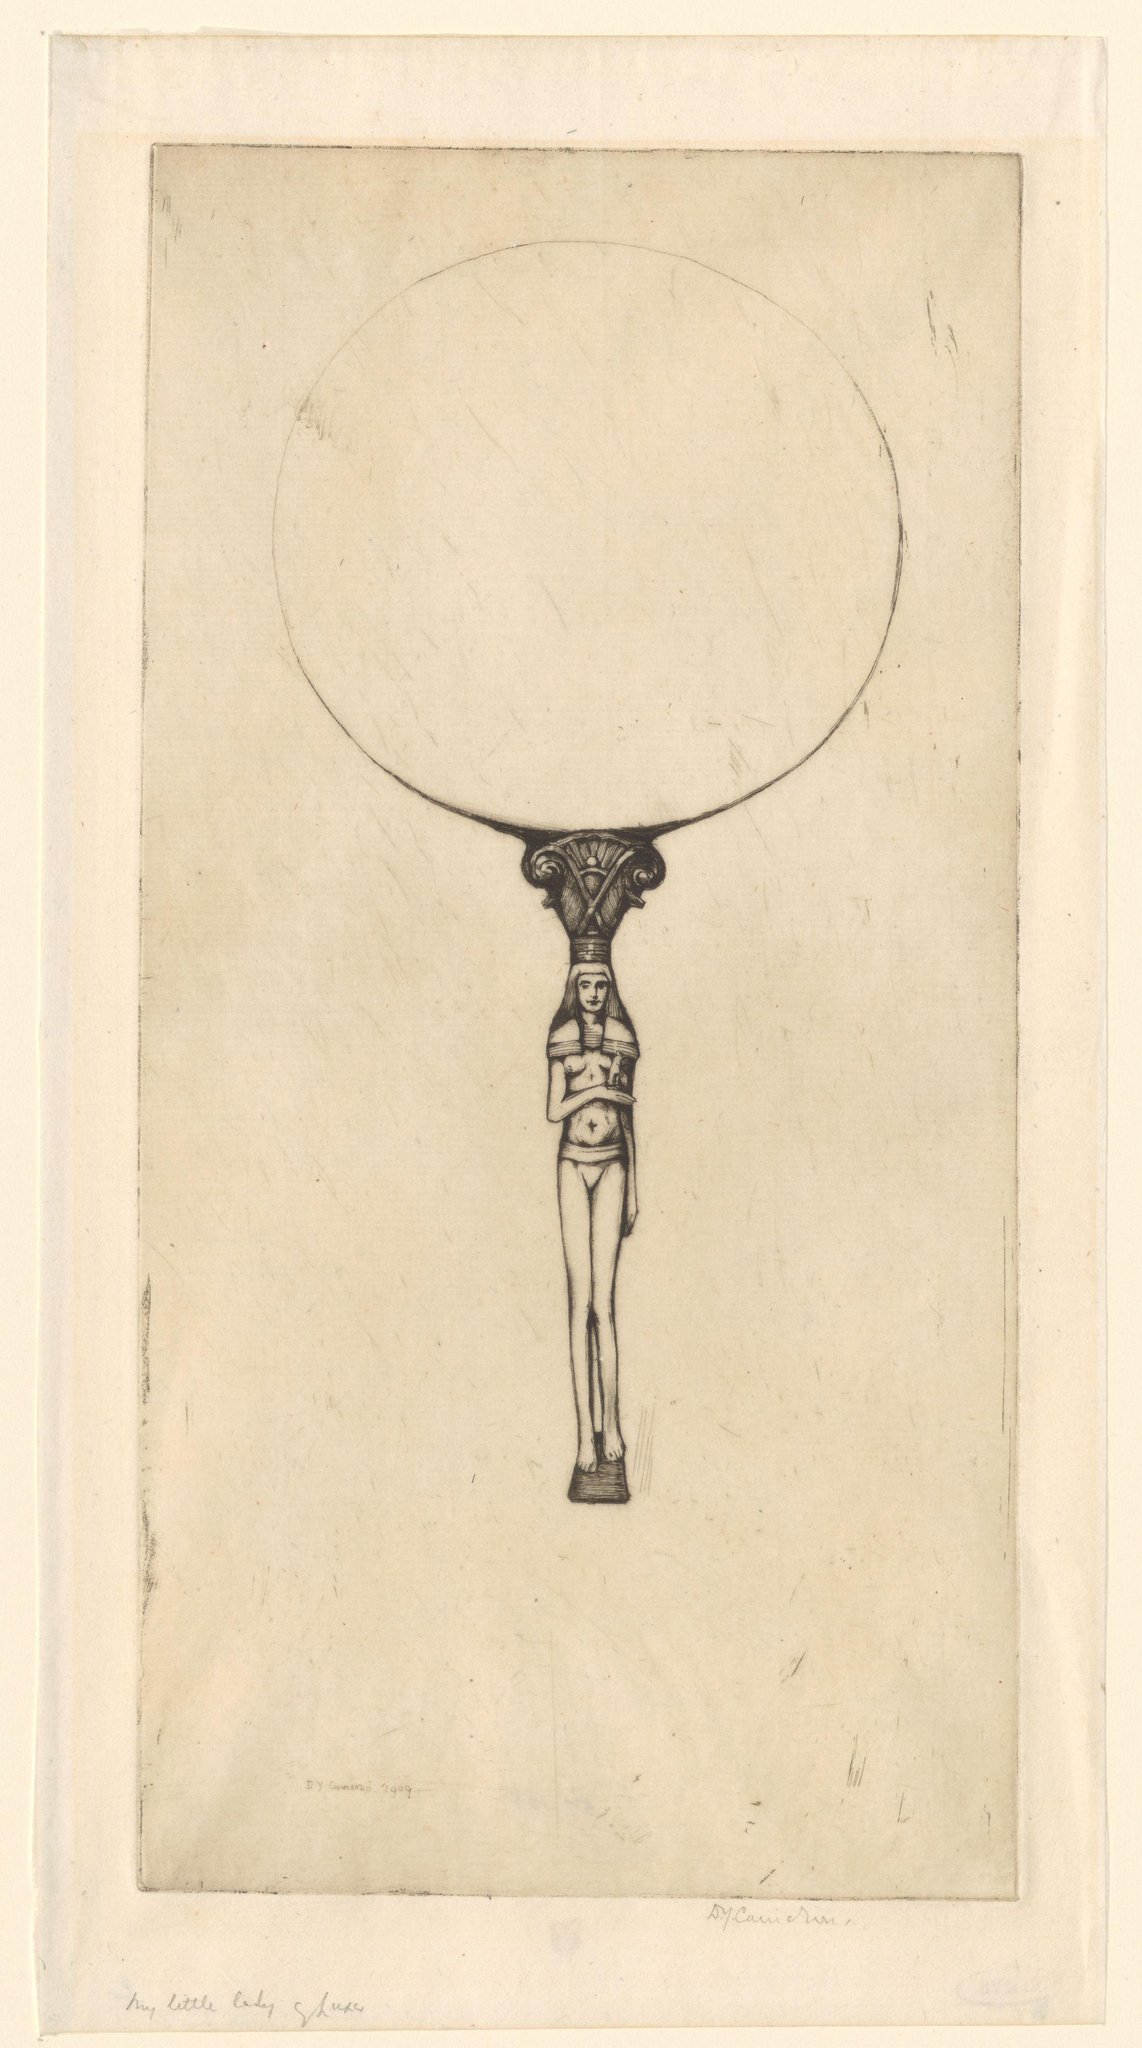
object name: print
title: My little lady of Luxor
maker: david young cameron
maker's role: draughtsman, print maker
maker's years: 1865-1945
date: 1909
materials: paper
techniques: drypoint, etching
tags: mirror, standing figure - aa - female human figure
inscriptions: collector's mark: Lugt 2228, collector's mark: Lugt 2760